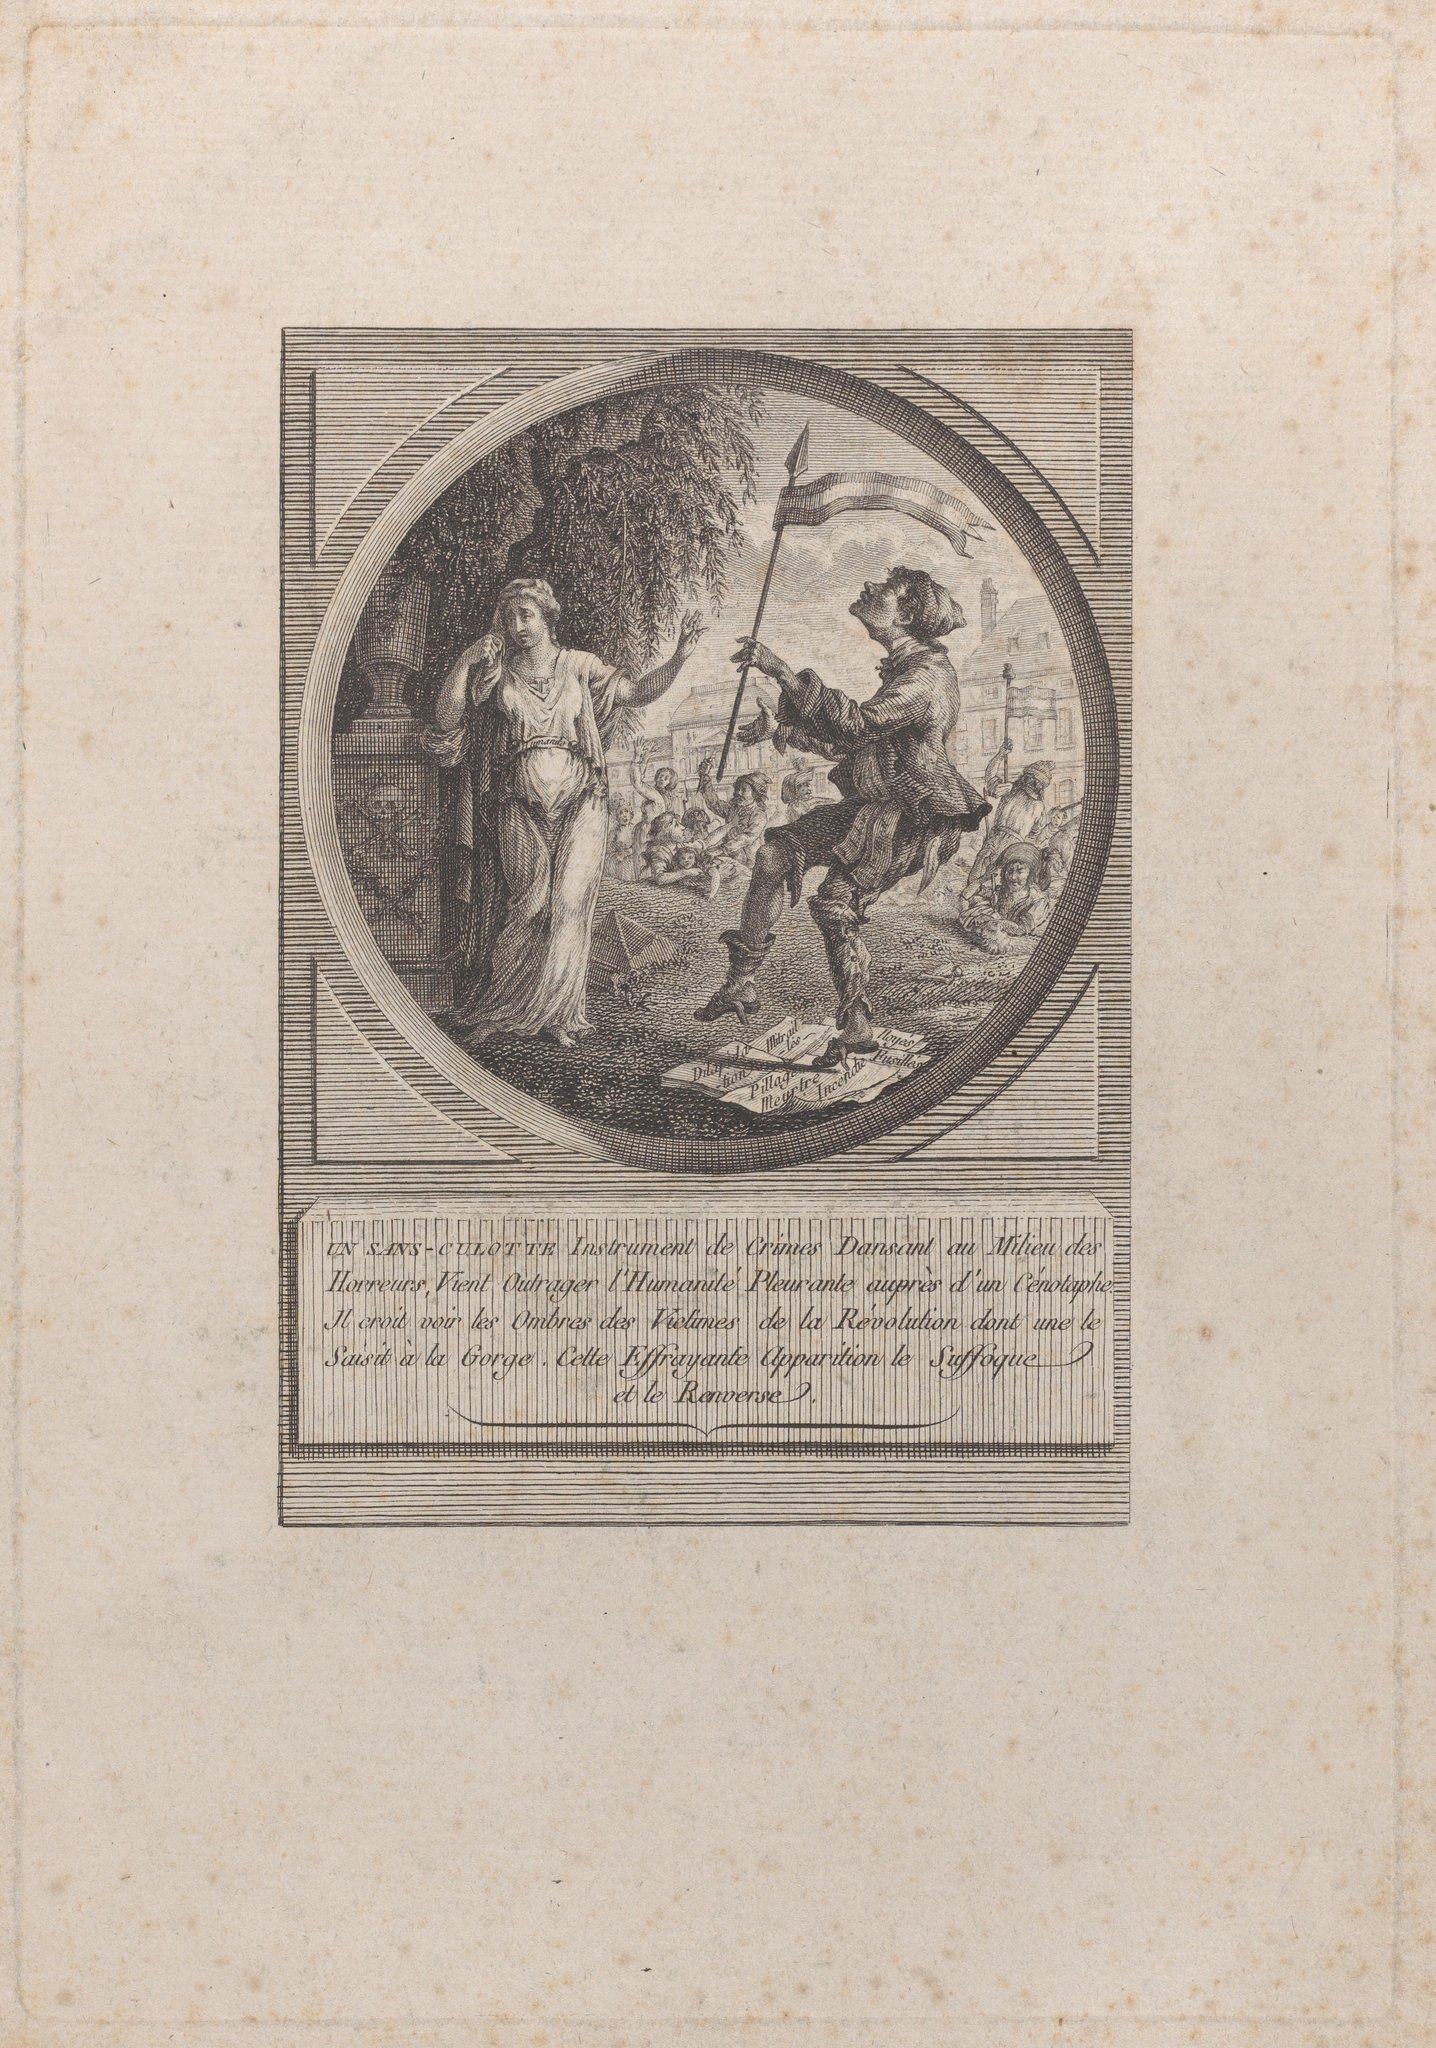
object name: print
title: Satire against the Terror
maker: Anonymous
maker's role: artist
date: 1794-1815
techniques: etching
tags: french revolution,louis xvi,men,women